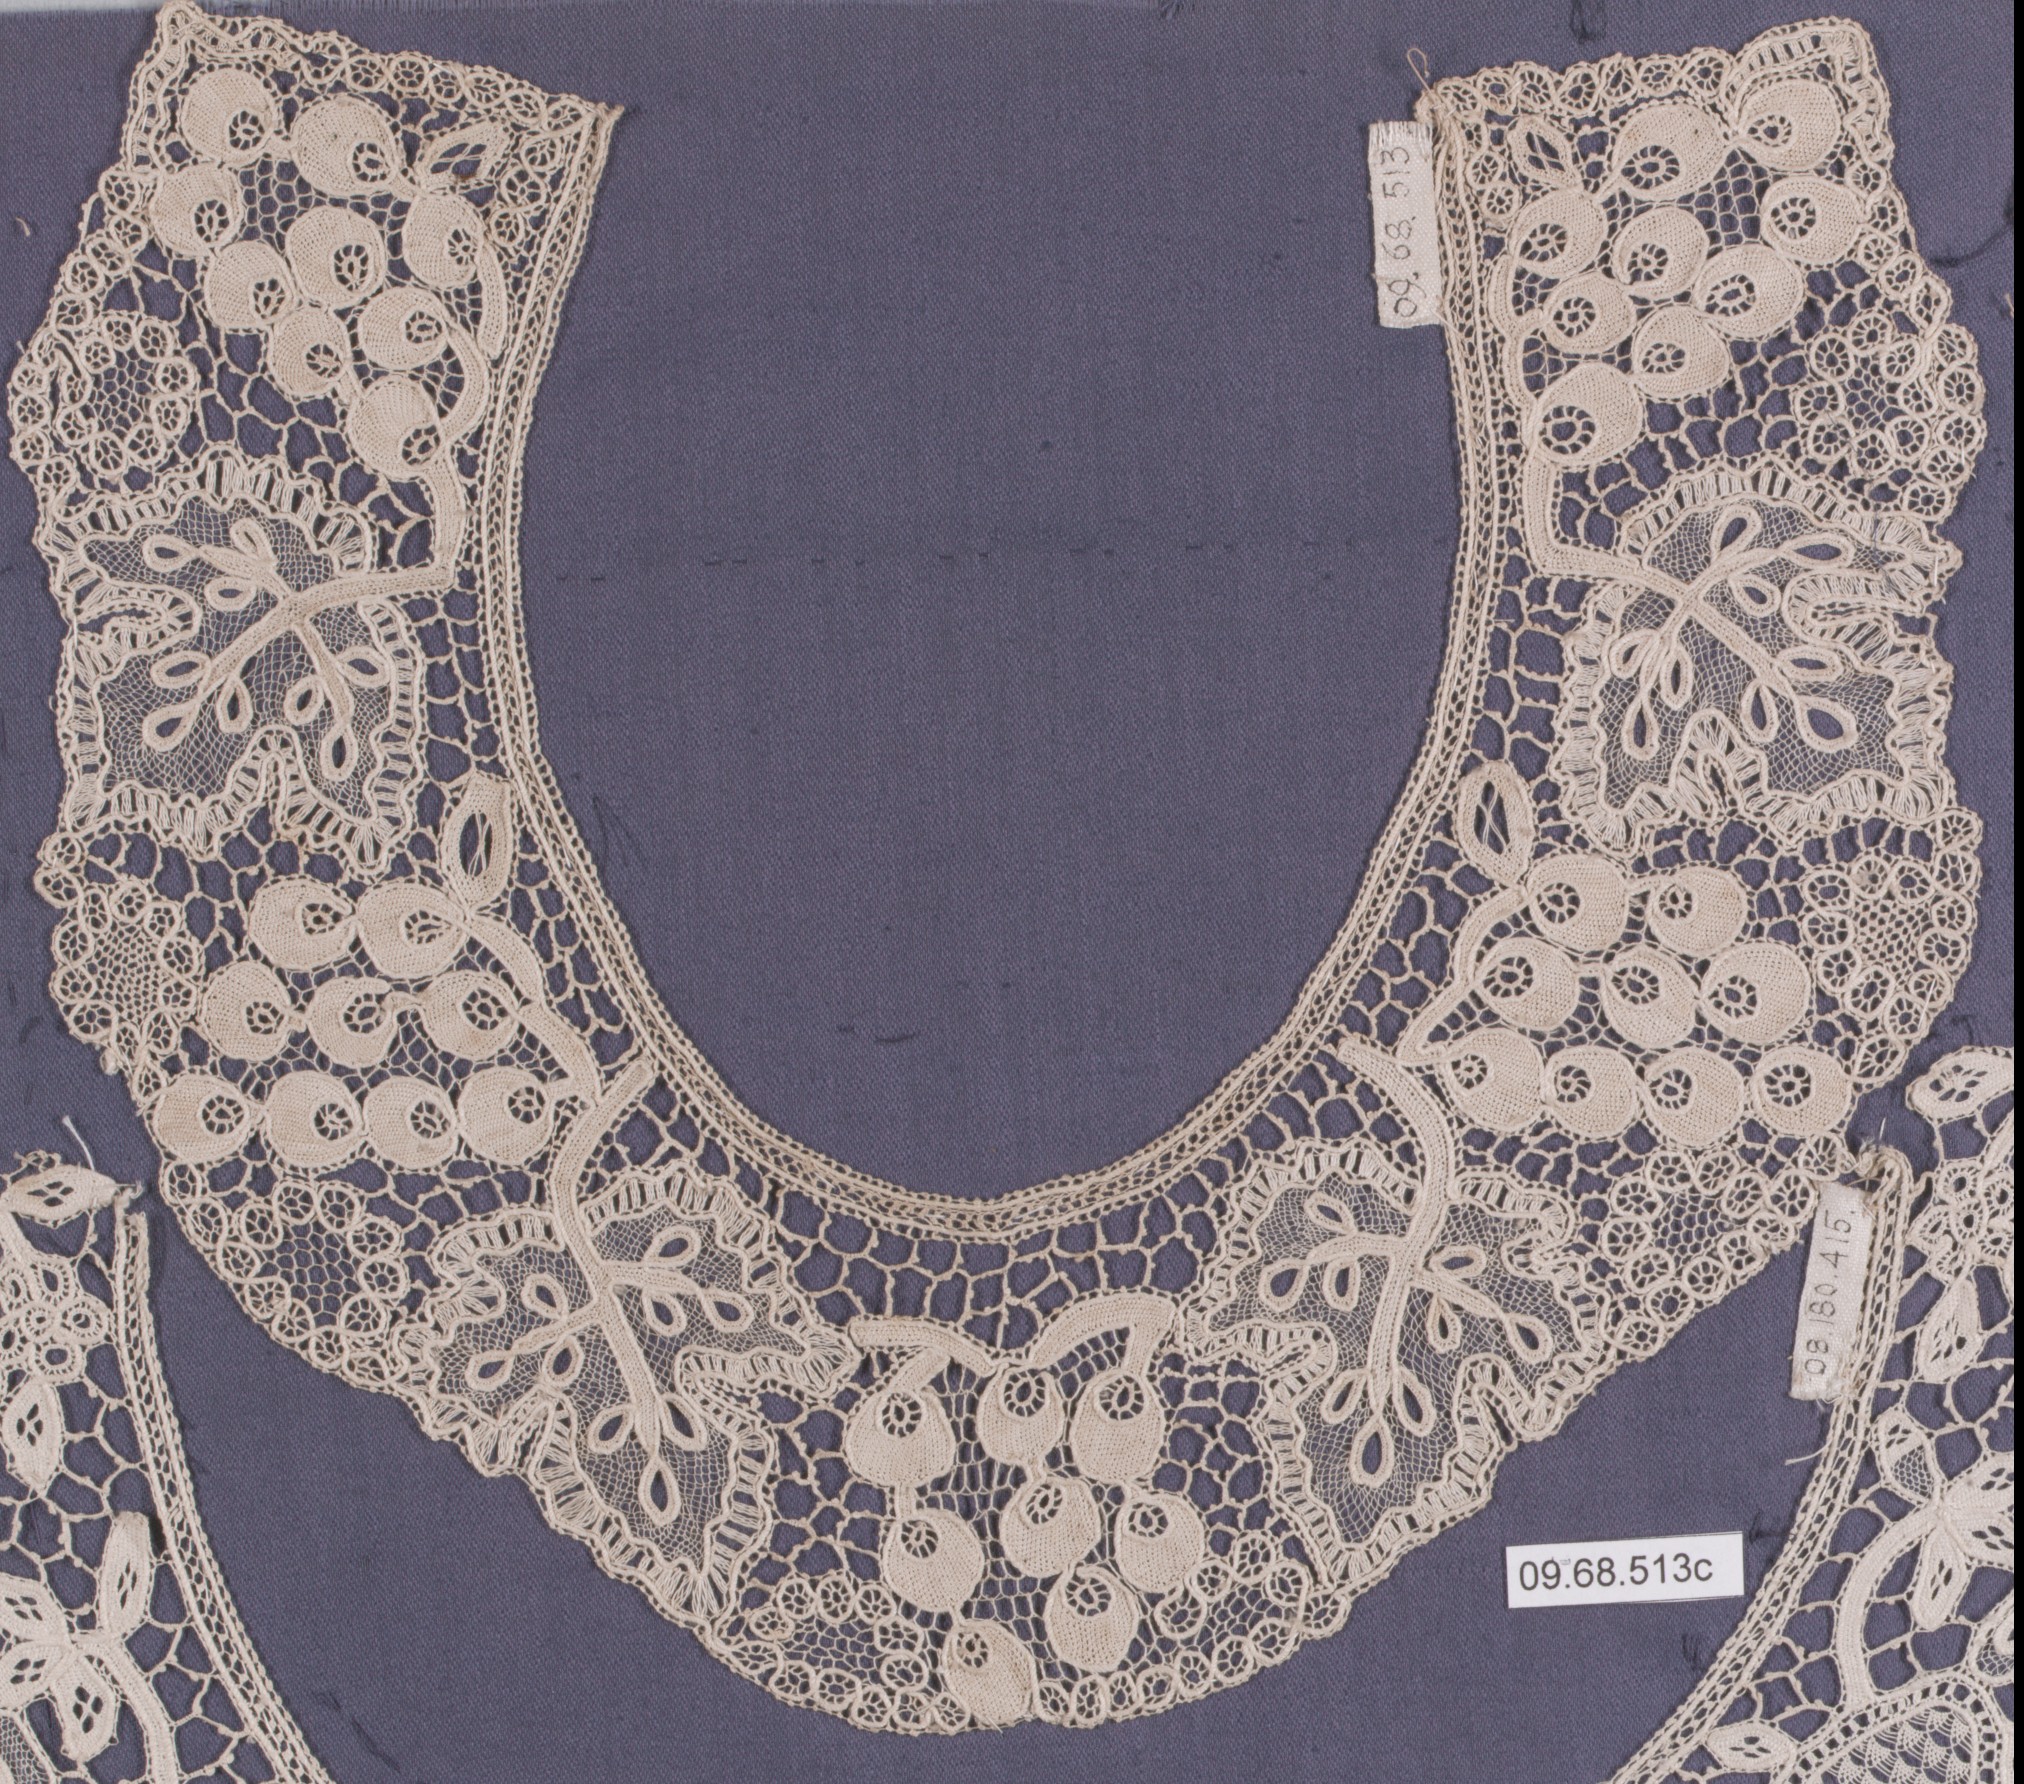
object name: collar and cuff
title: Collar and cuffs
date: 1801-1900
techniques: lace